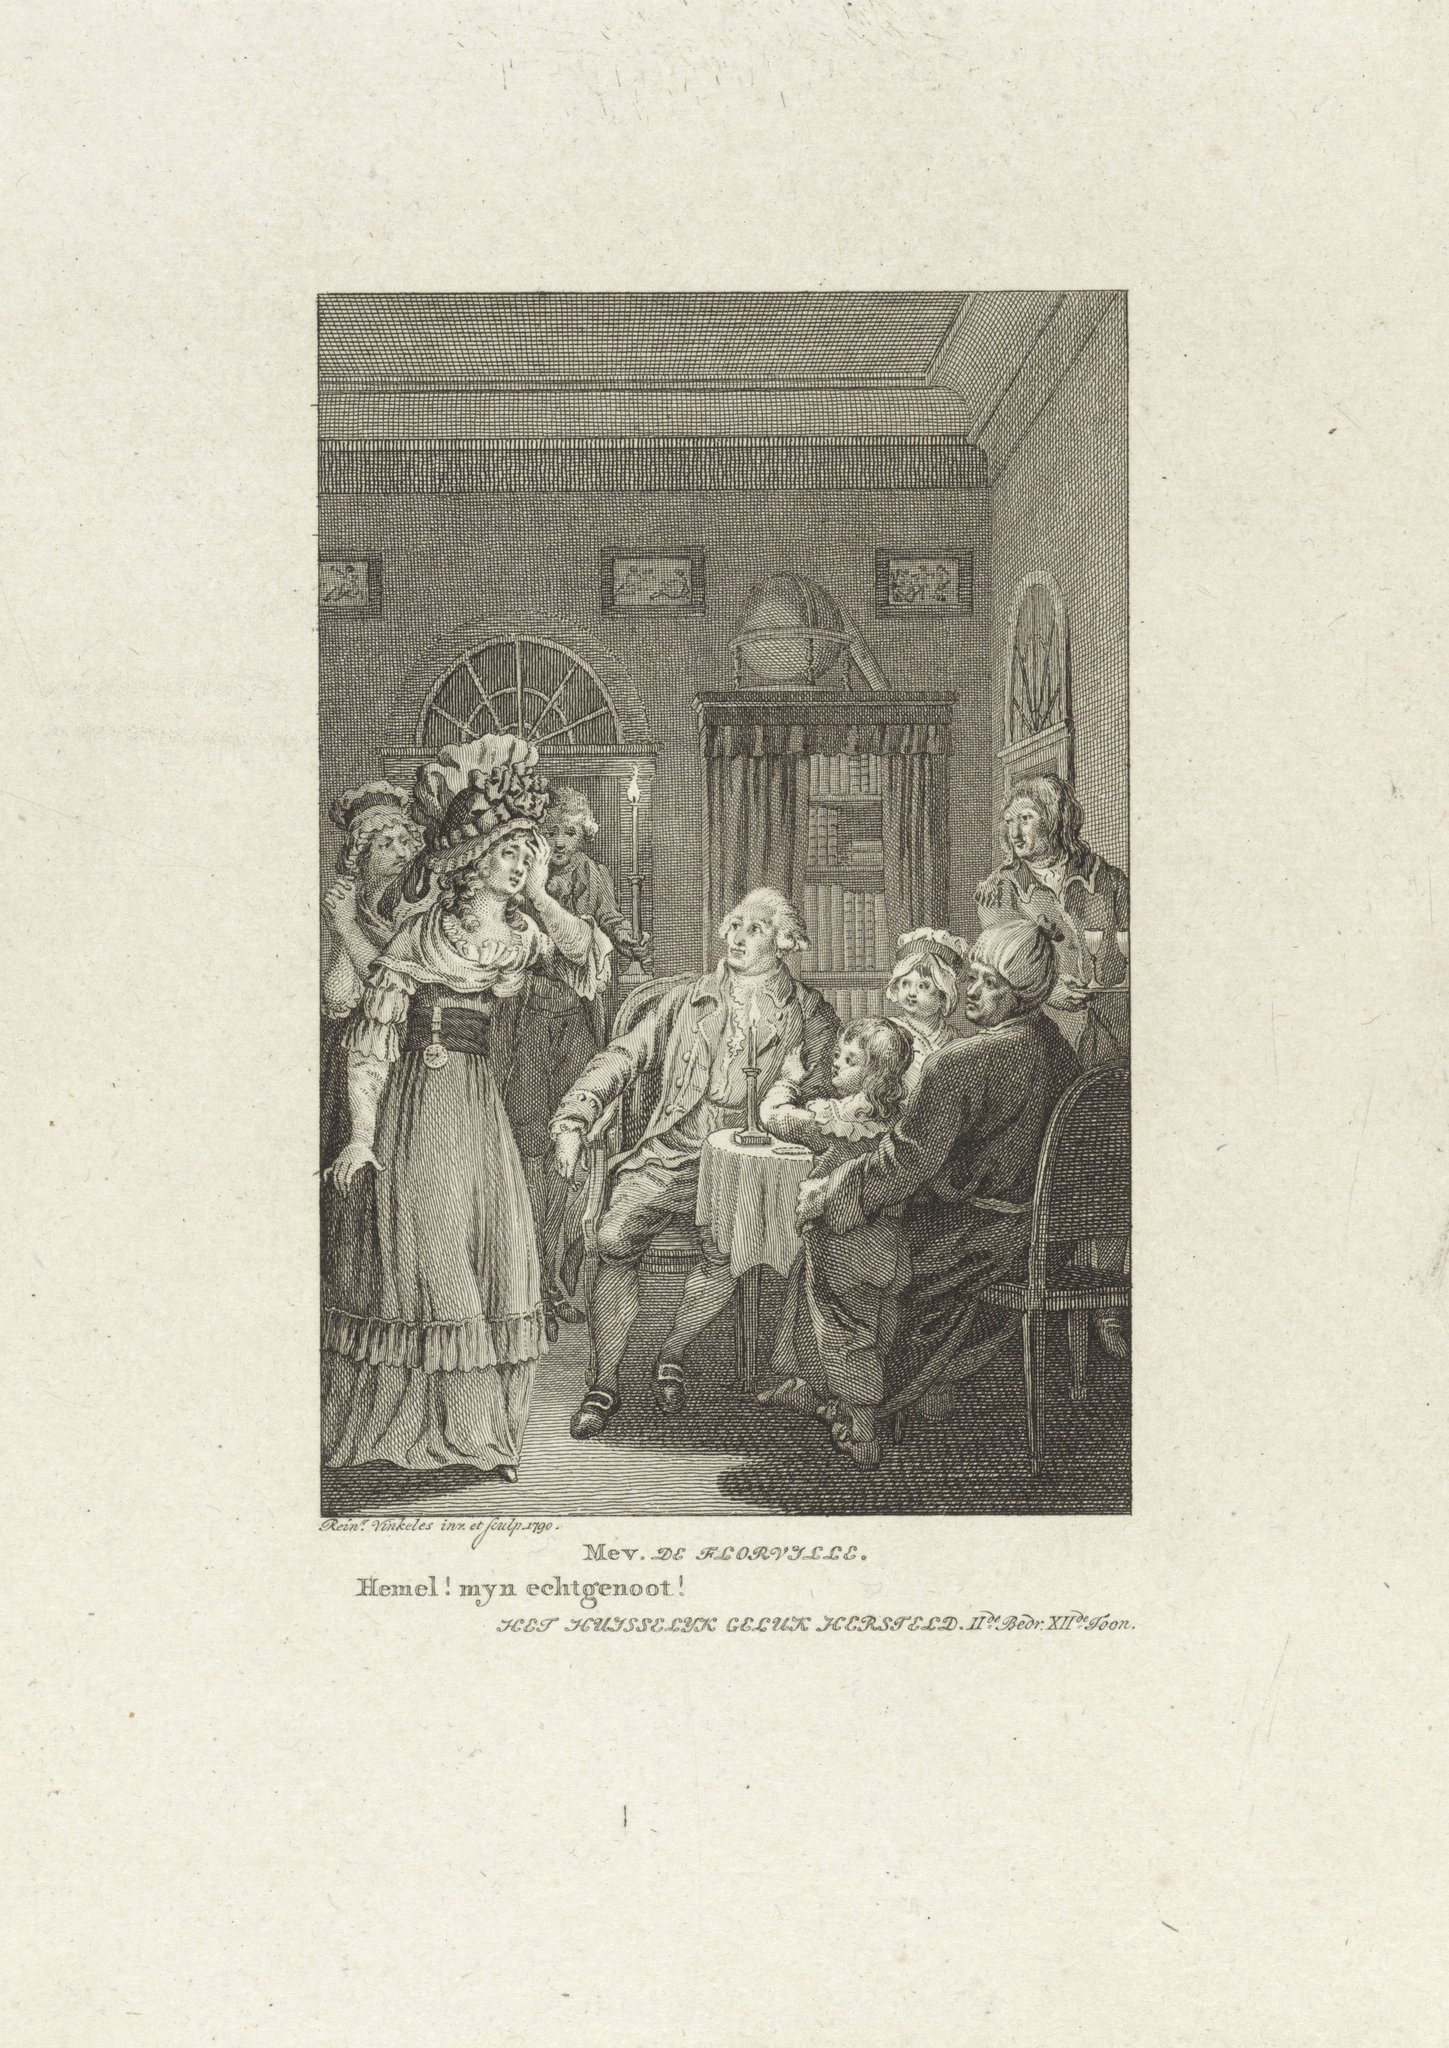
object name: print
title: Mevrouw de Florville in verwondering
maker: reinier vinkeles (i)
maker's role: draughtsman, print maker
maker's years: 1741-1816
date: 1790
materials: paper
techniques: engraving, etching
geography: amsterdam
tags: surprise, wonder; 'maraviglia' (ripa) (+ variant)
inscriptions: collector's mark: Lugt 240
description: Deze prent is ook gebruikt als illustratie in: Spectatoriaale schouwburg, behelzende eene verzameling der beste (...), deel 19. Amsterdam: erven van Pieter Meijer en Gerrit Warnars, 1790, p. 326.